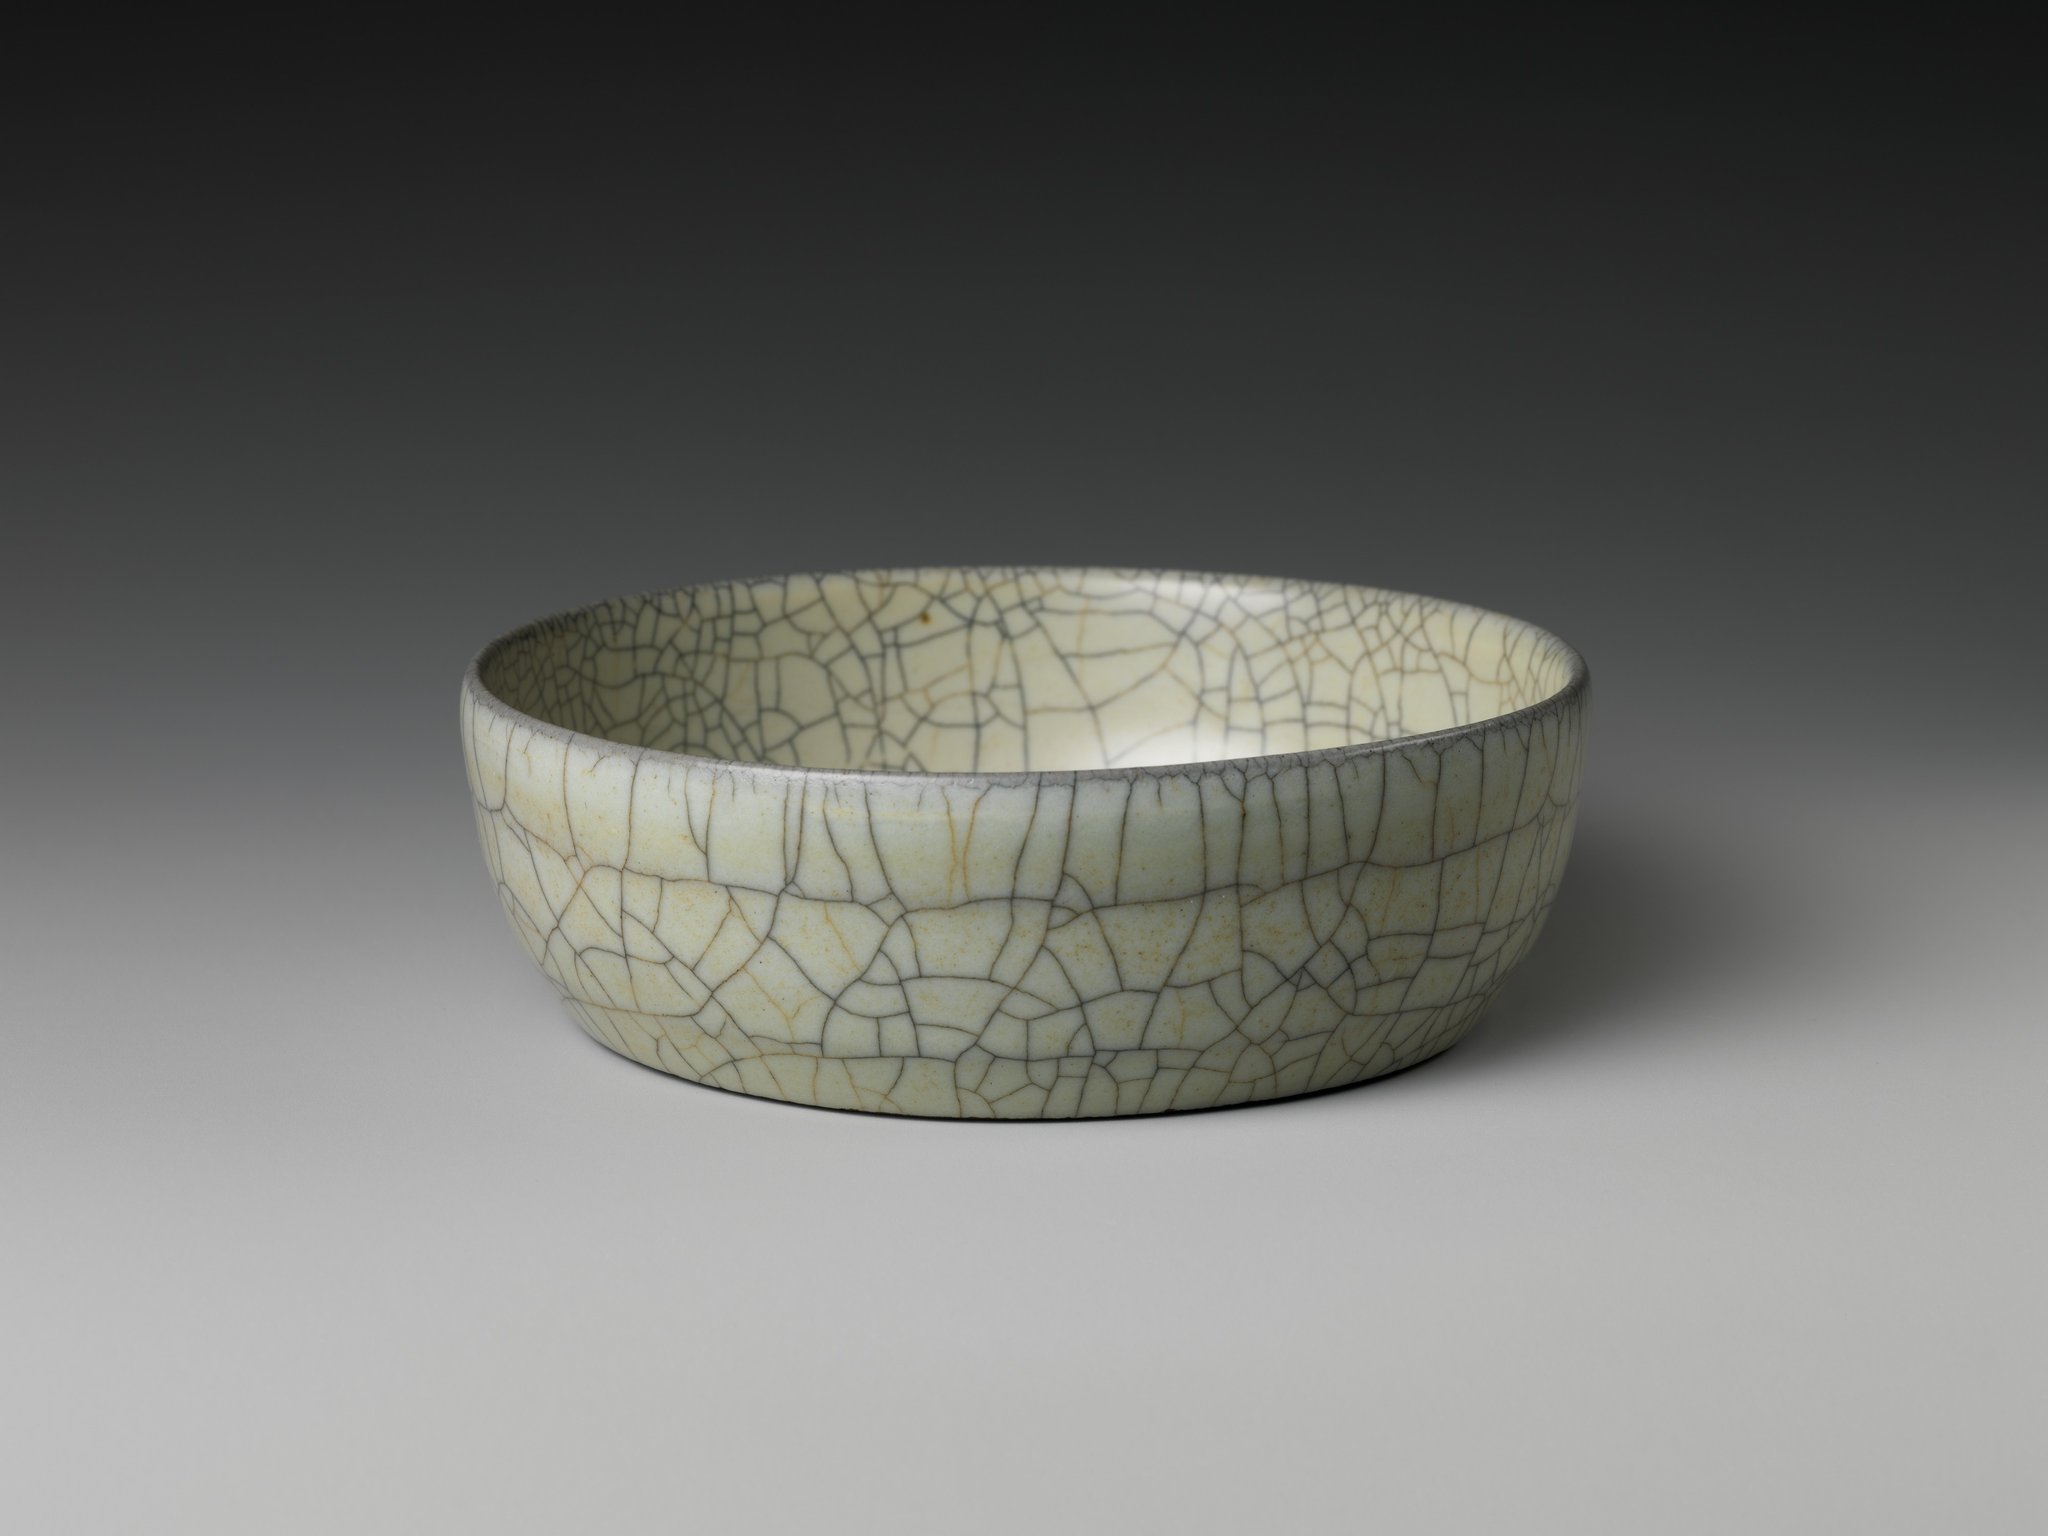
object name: brush washer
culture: chinese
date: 1201-1400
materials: glaze, stoneware